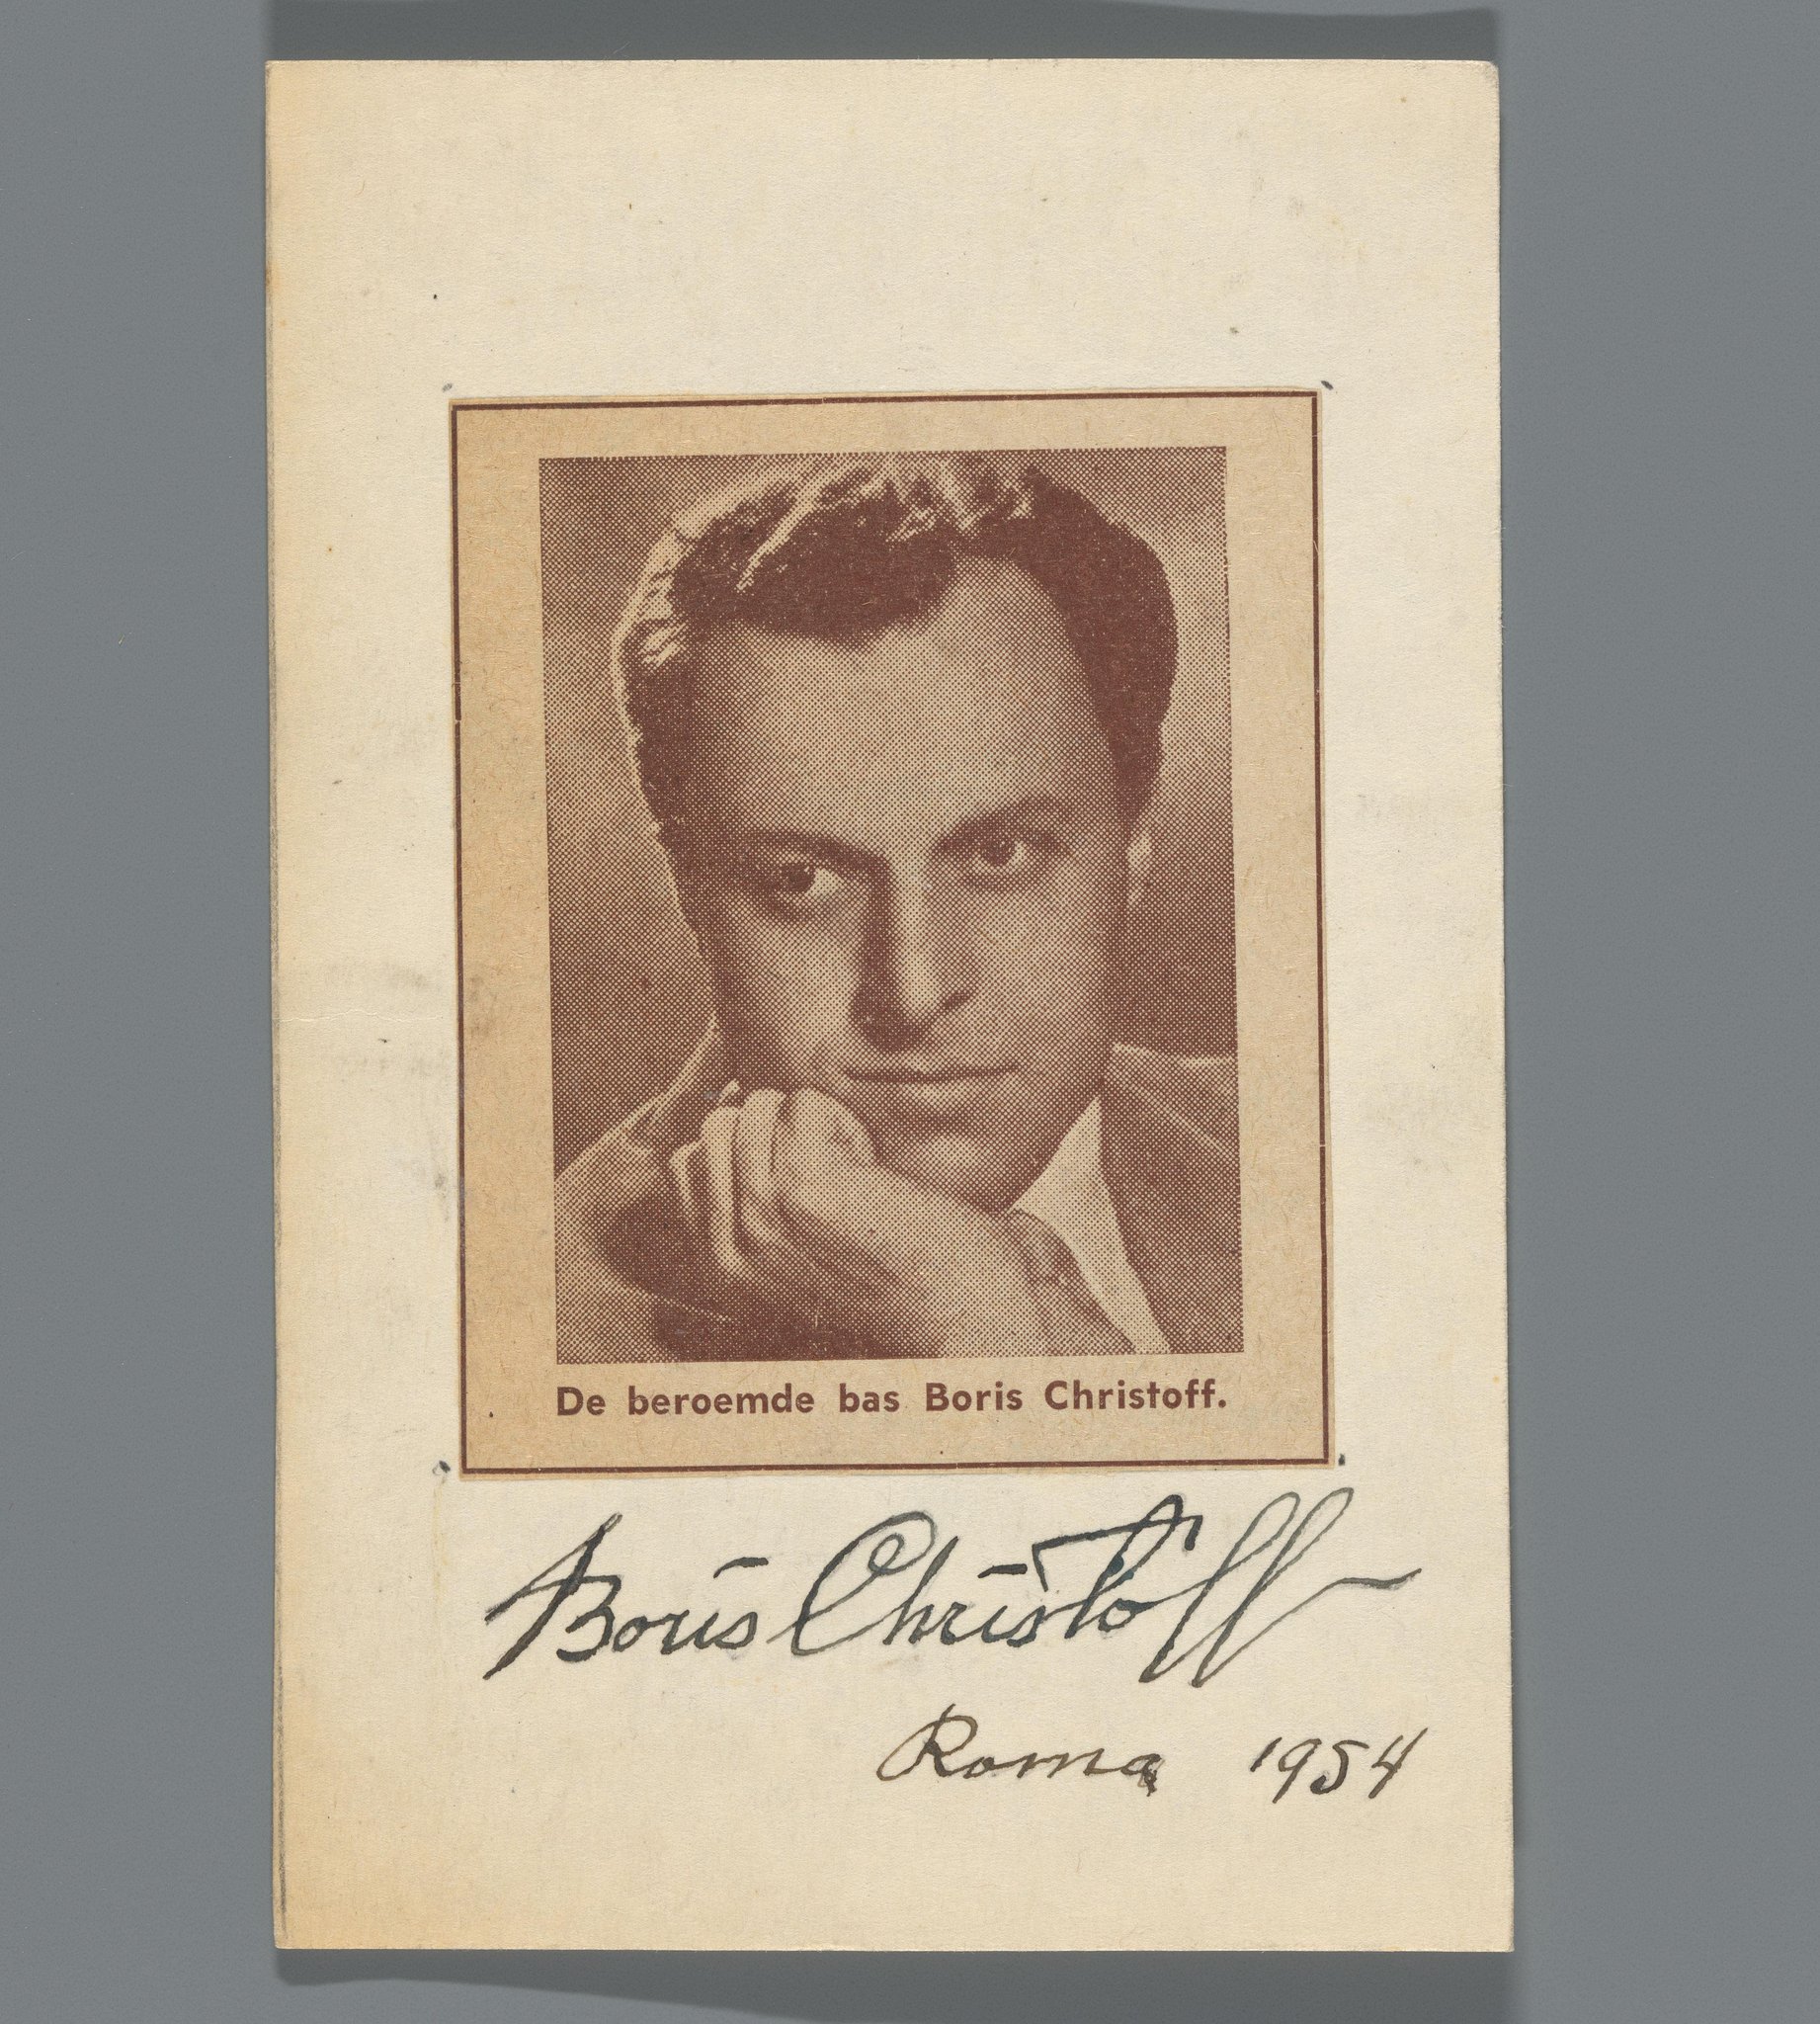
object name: photomechanical print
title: De beroemde bas Boris Christoff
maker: Anonymous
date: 1954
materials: cardboard, ink, paper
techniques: pen, writing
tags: rome, portrait of opera-singer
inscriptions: signature: ‘Boris Christoff/ Roma 1954’, inscription: ‘Boris Christoff werd geboren op (...)’